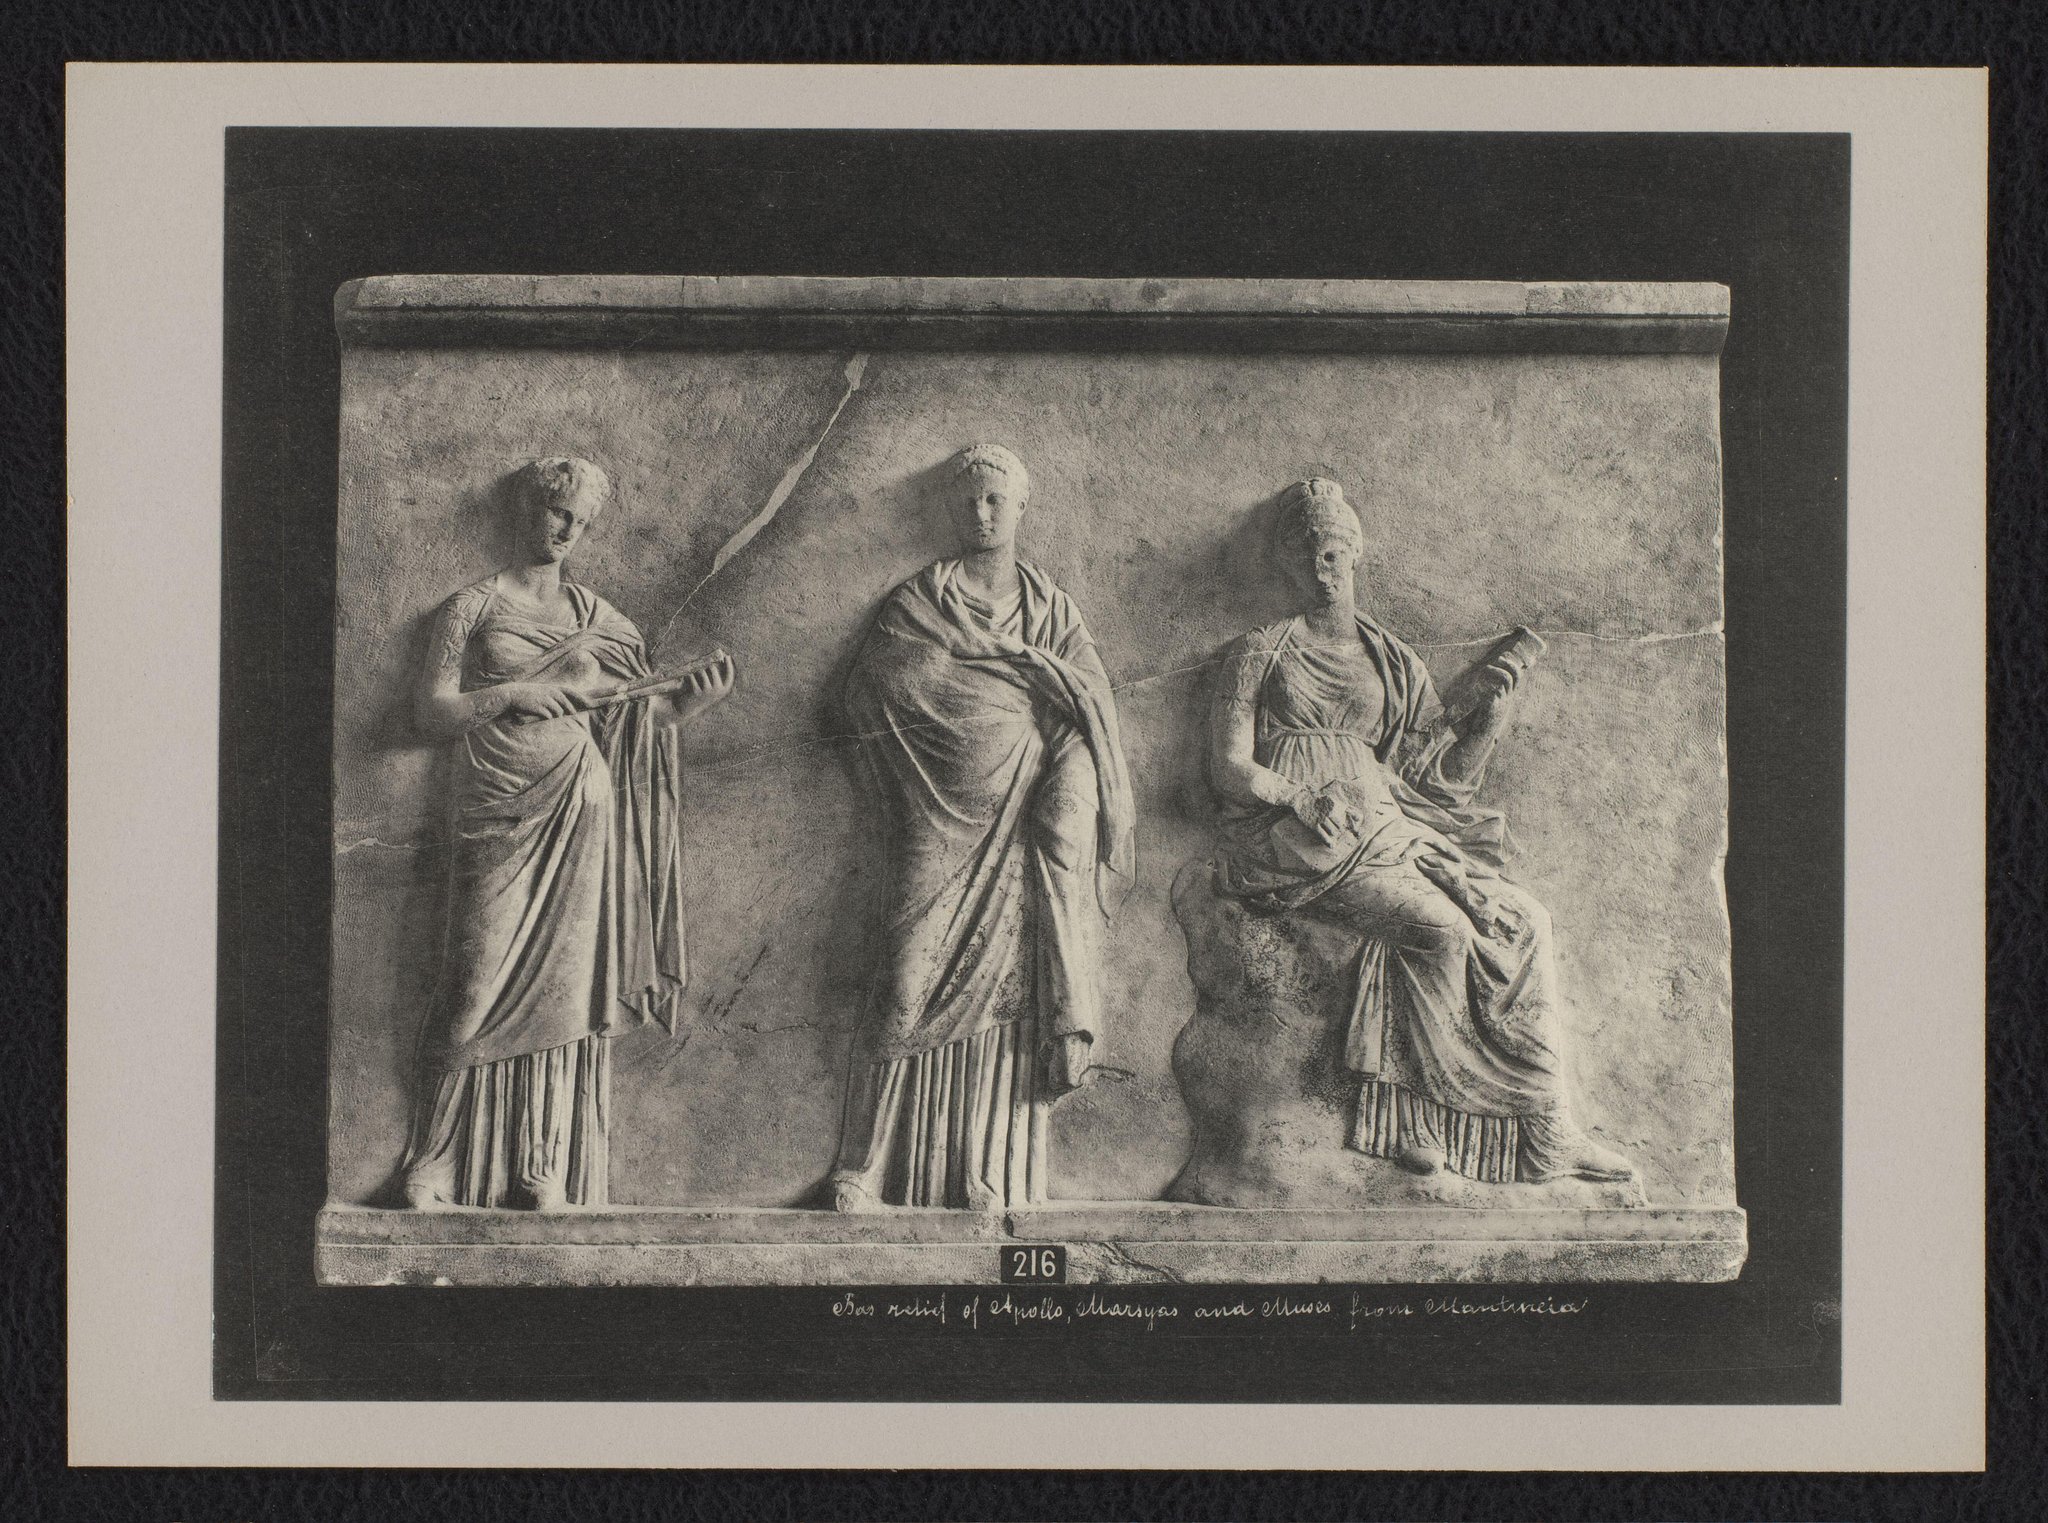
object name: photograph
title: Bas relief of Apollo, Marsyas and Muses from Mantineia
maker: Anonymous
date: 1895-1915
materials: cardboard, paper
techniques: photograph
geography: athens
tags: athene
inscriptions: number: ‘42.’